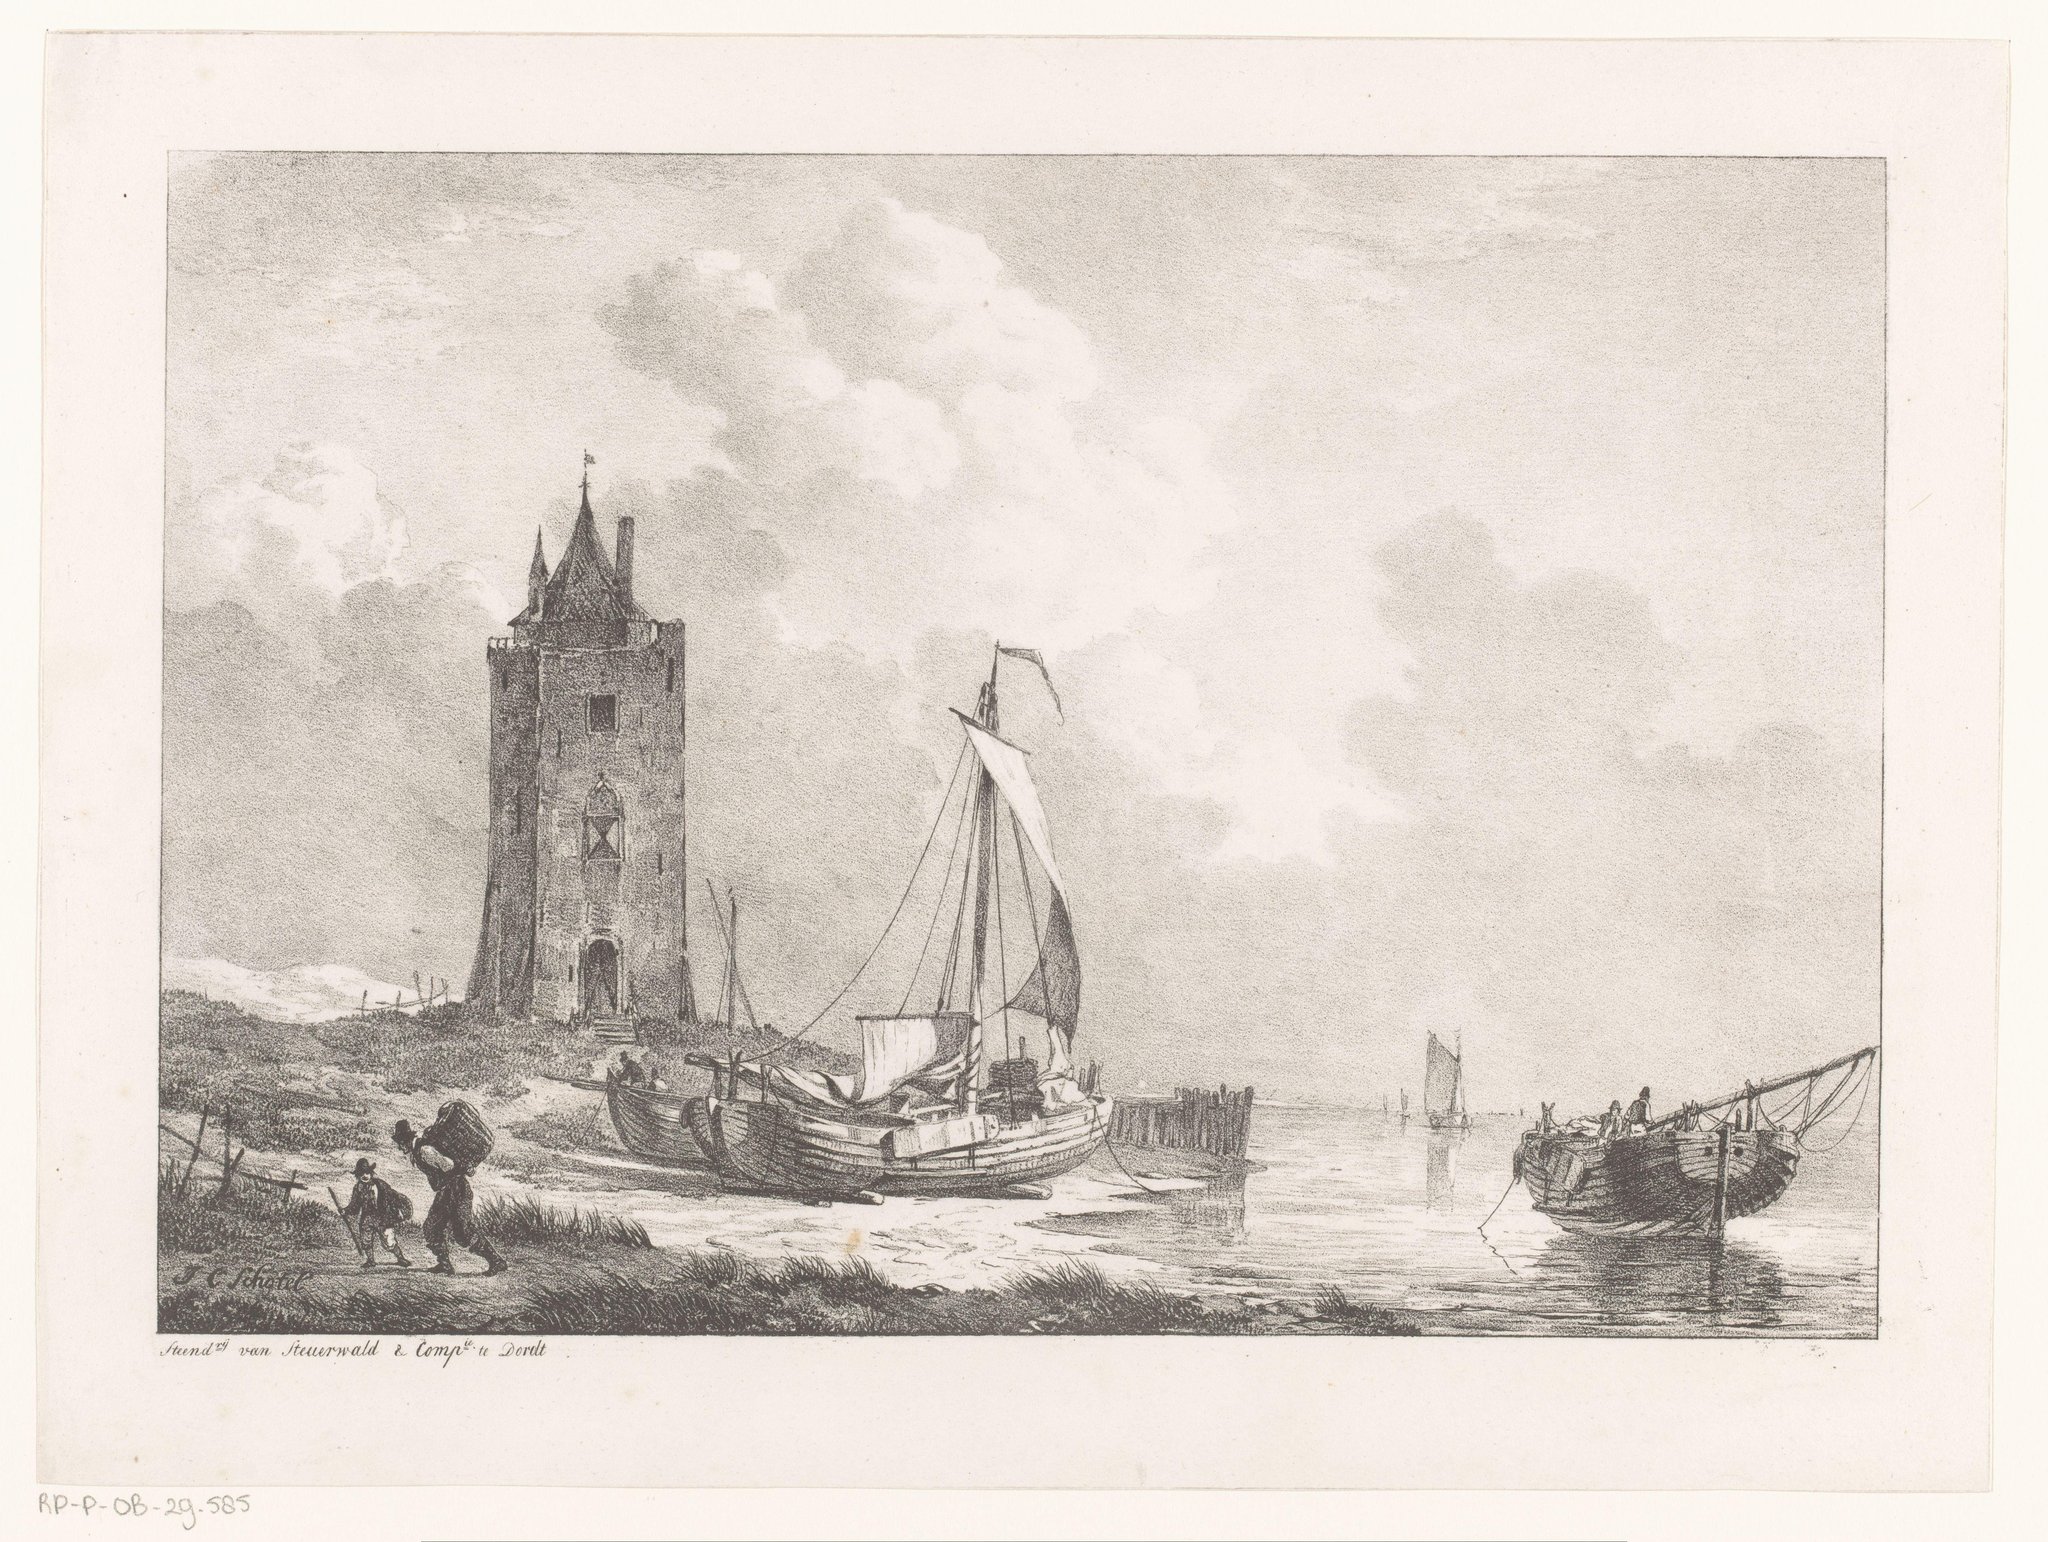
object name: print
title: Kustlandschap met toren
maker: johannes christiaan schotel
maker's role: draughtsman, painter, print maker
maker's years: 1787-1838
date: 1826-1833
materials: paper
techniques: lithograph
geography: dordrecht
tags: sailing-ship, sailing-boat, landscapes with waters, waterscapes, seascapes (in the temperate zone), landscape with tower or castle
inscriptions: collector's mark: Lugt 2165, inscription: ‘15A / 12-6-'79’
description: Op het strand liggen twee zeilboten voor een toren. Links wandelen twee figuren met manden. Rechts varen zeilboten op zee.